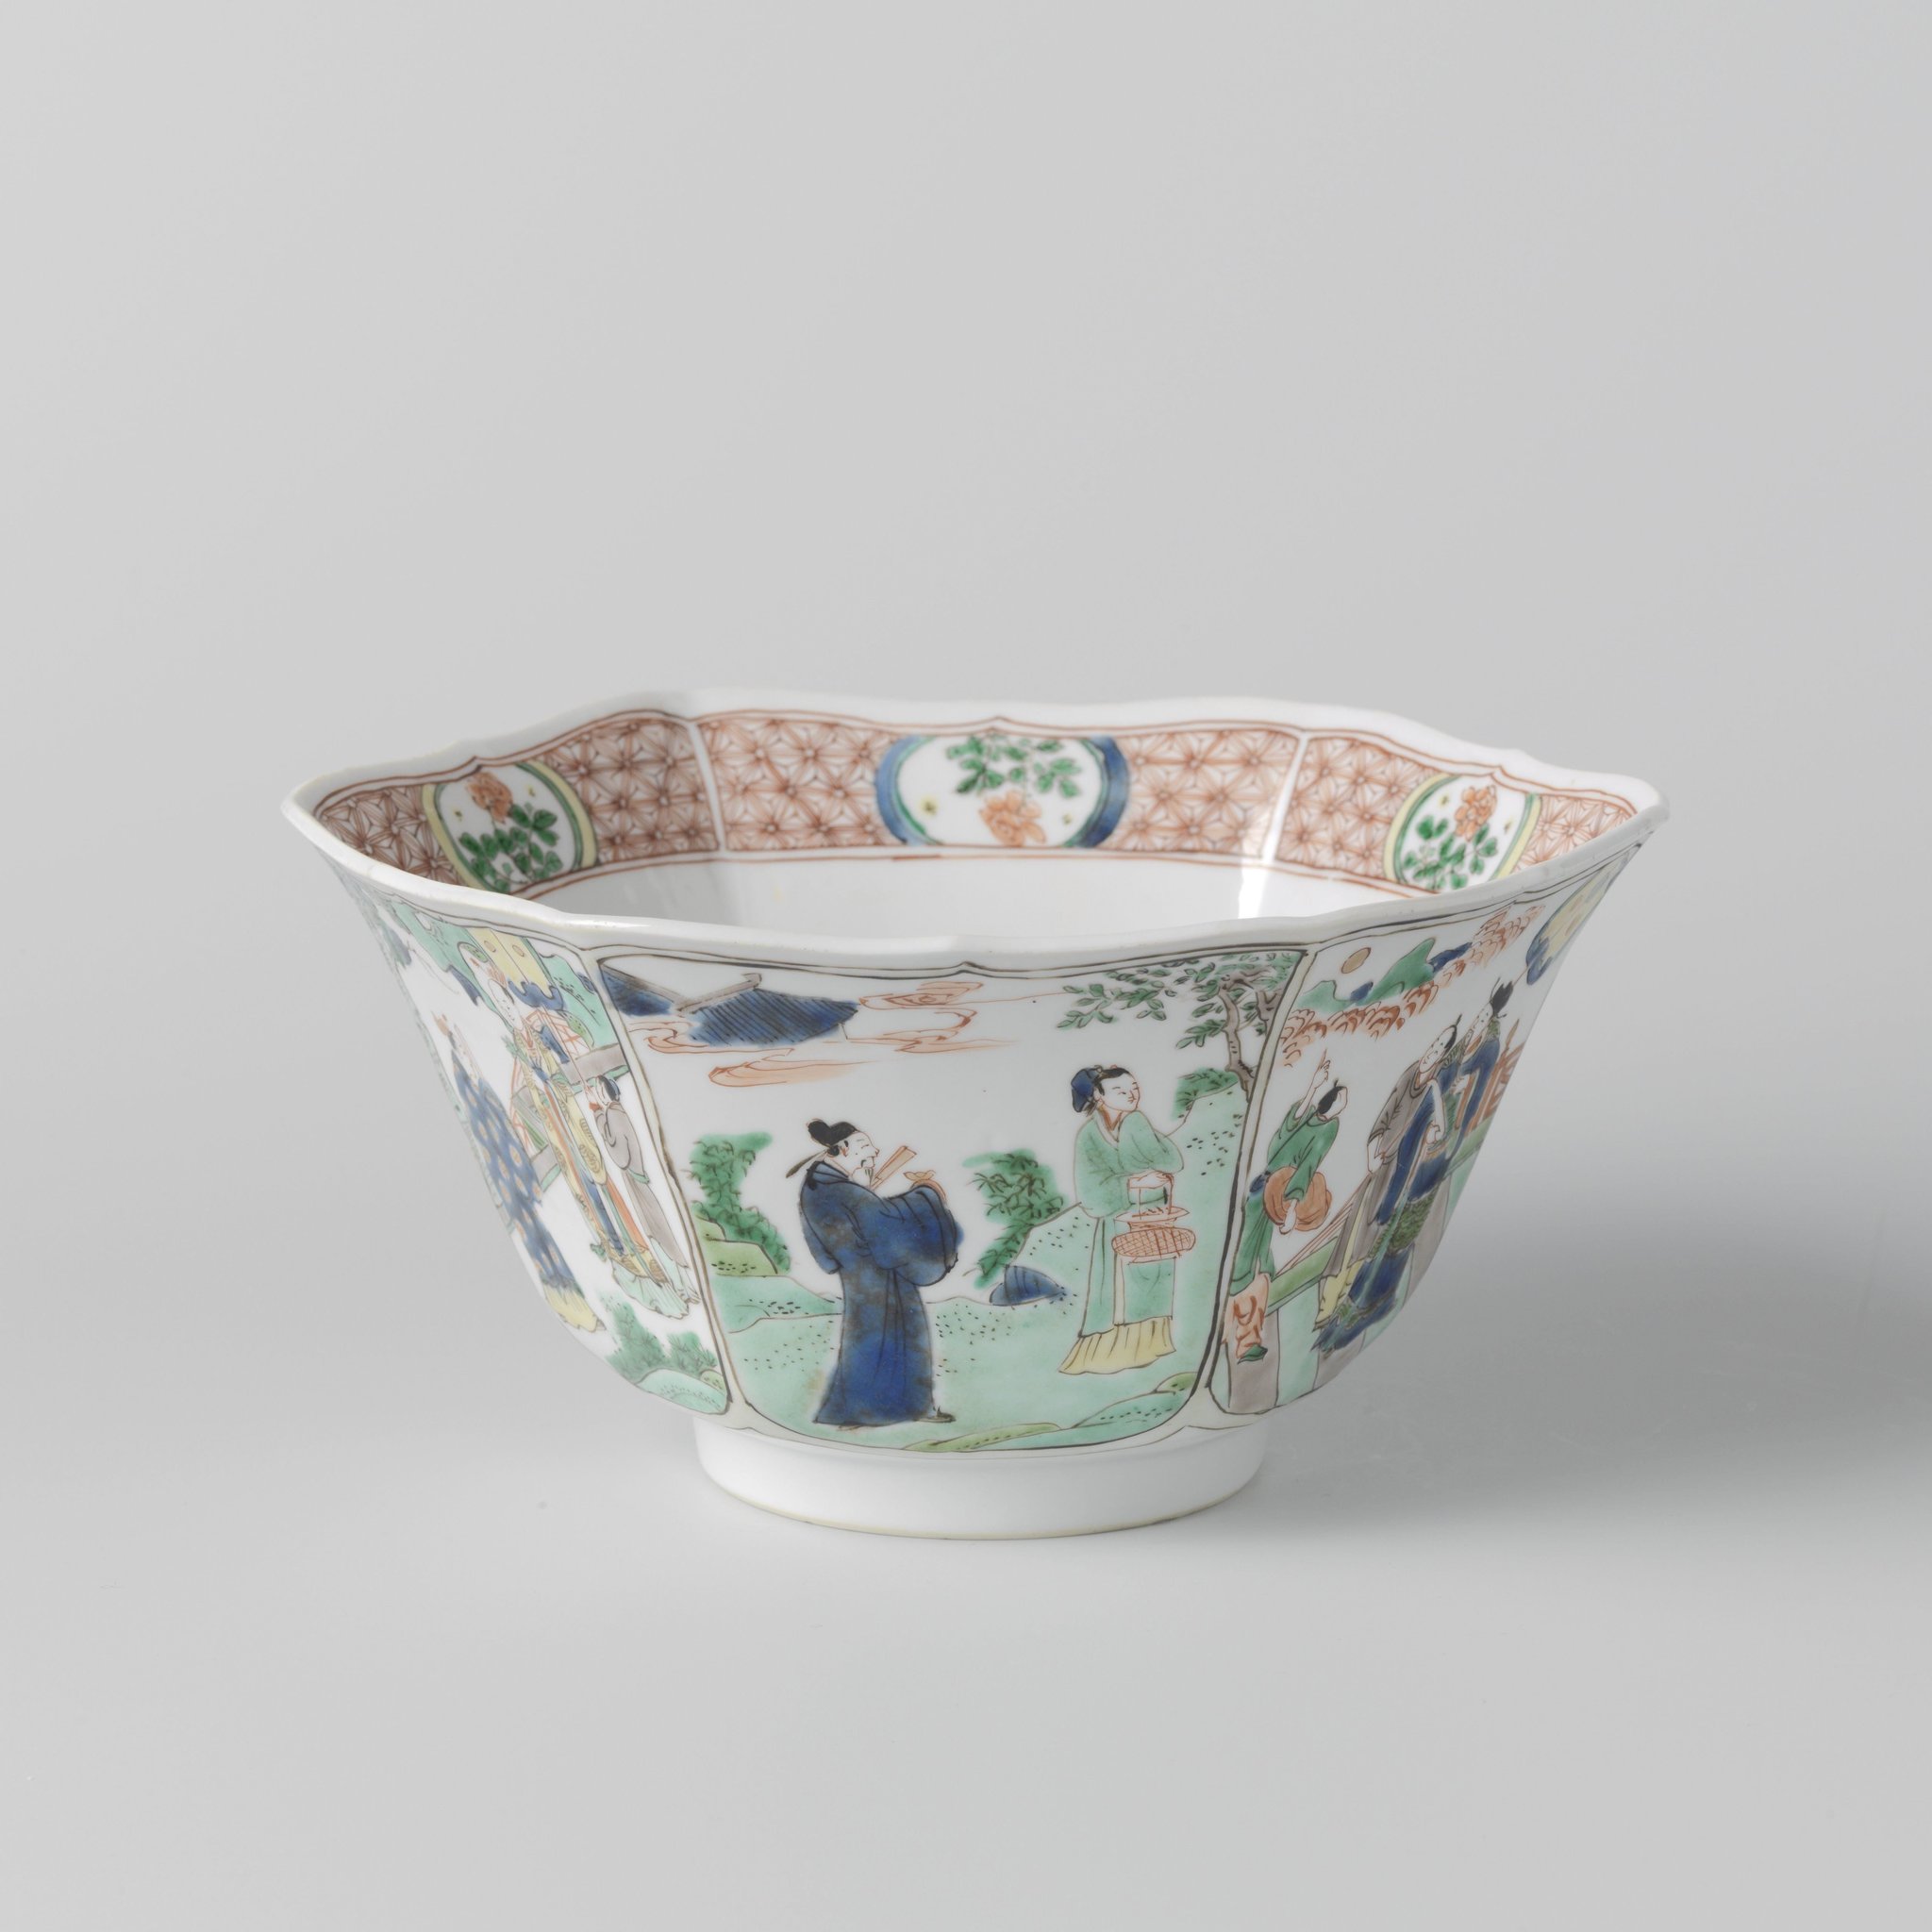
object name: bowl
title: Hexagonal bowl with narrative scenes concerning Lü Dongbin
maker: Anonymous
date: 1700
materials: glaze, gold, paint, porcelain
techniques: firing, gilding, turning, vitrification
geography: china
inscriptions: mark: ‘大 明 成 化 年 製’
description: Kom, zeszijdig, famille verte, op de wand figurale voorstellingen in een landschap.